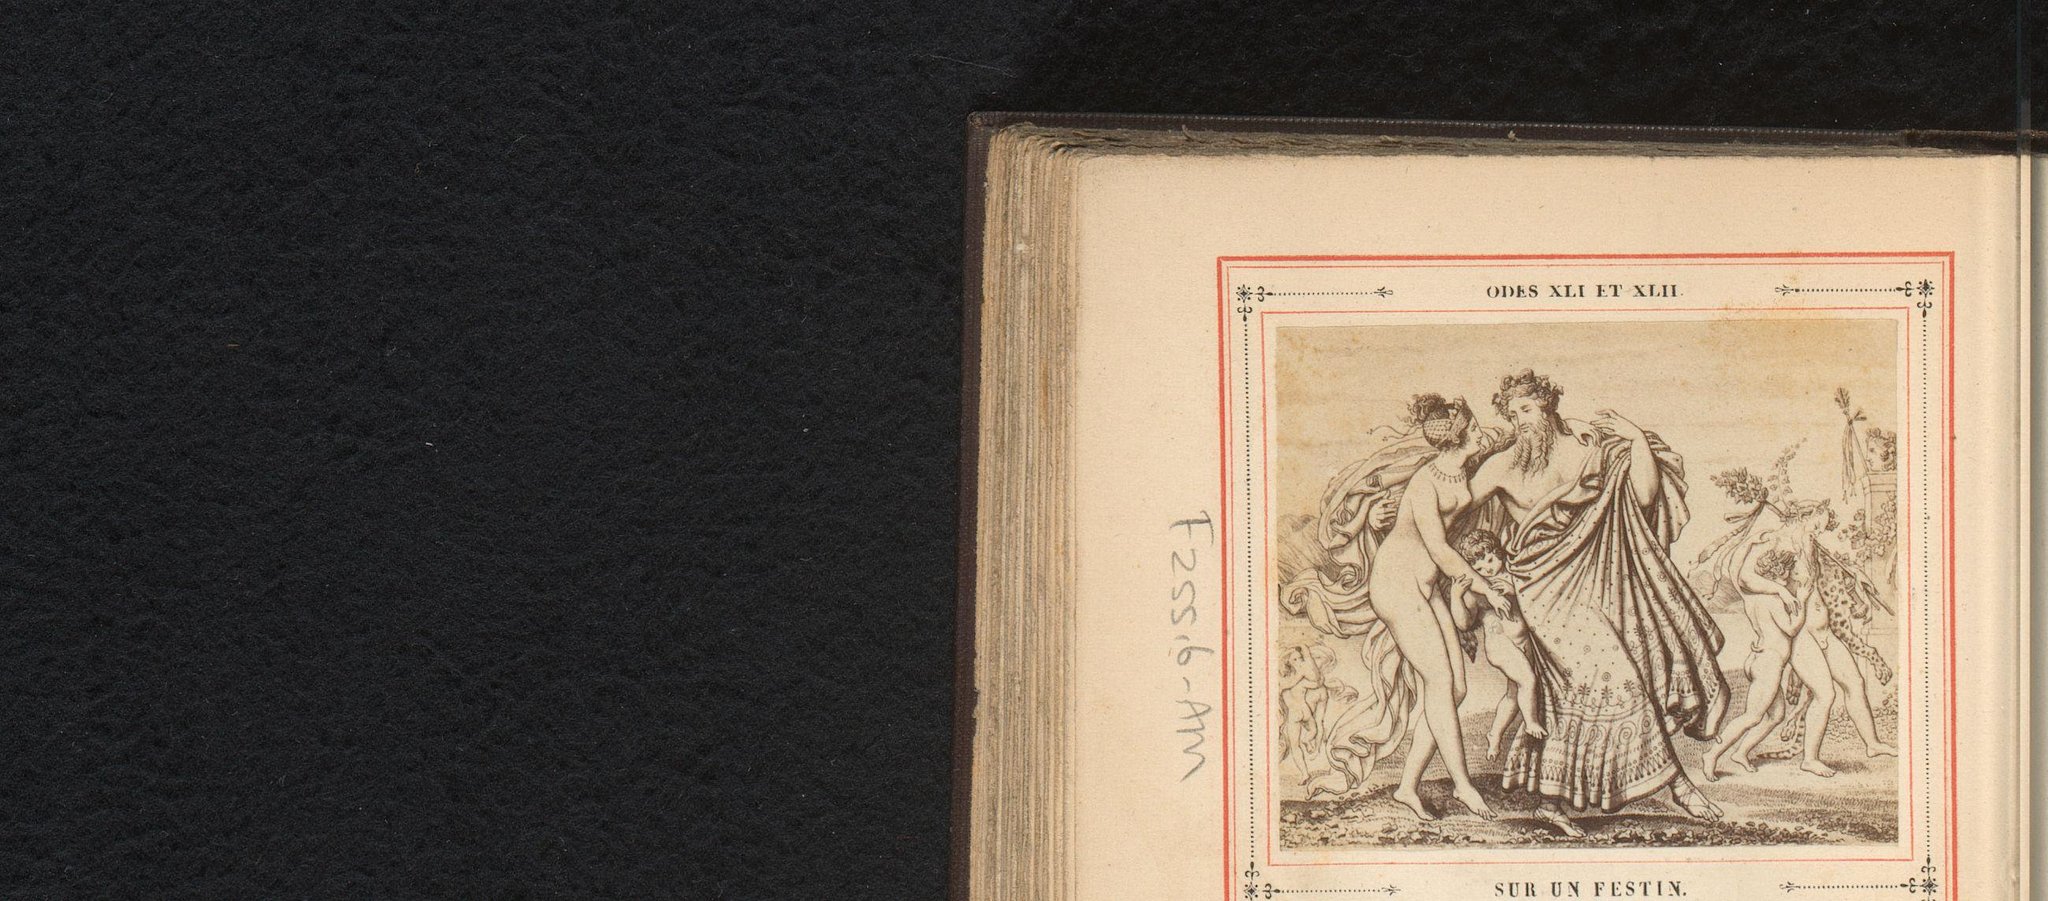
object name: reproduction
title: Sur un festin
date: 1859-1864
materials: paper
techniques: albumen print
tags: gods ~ classical mythology